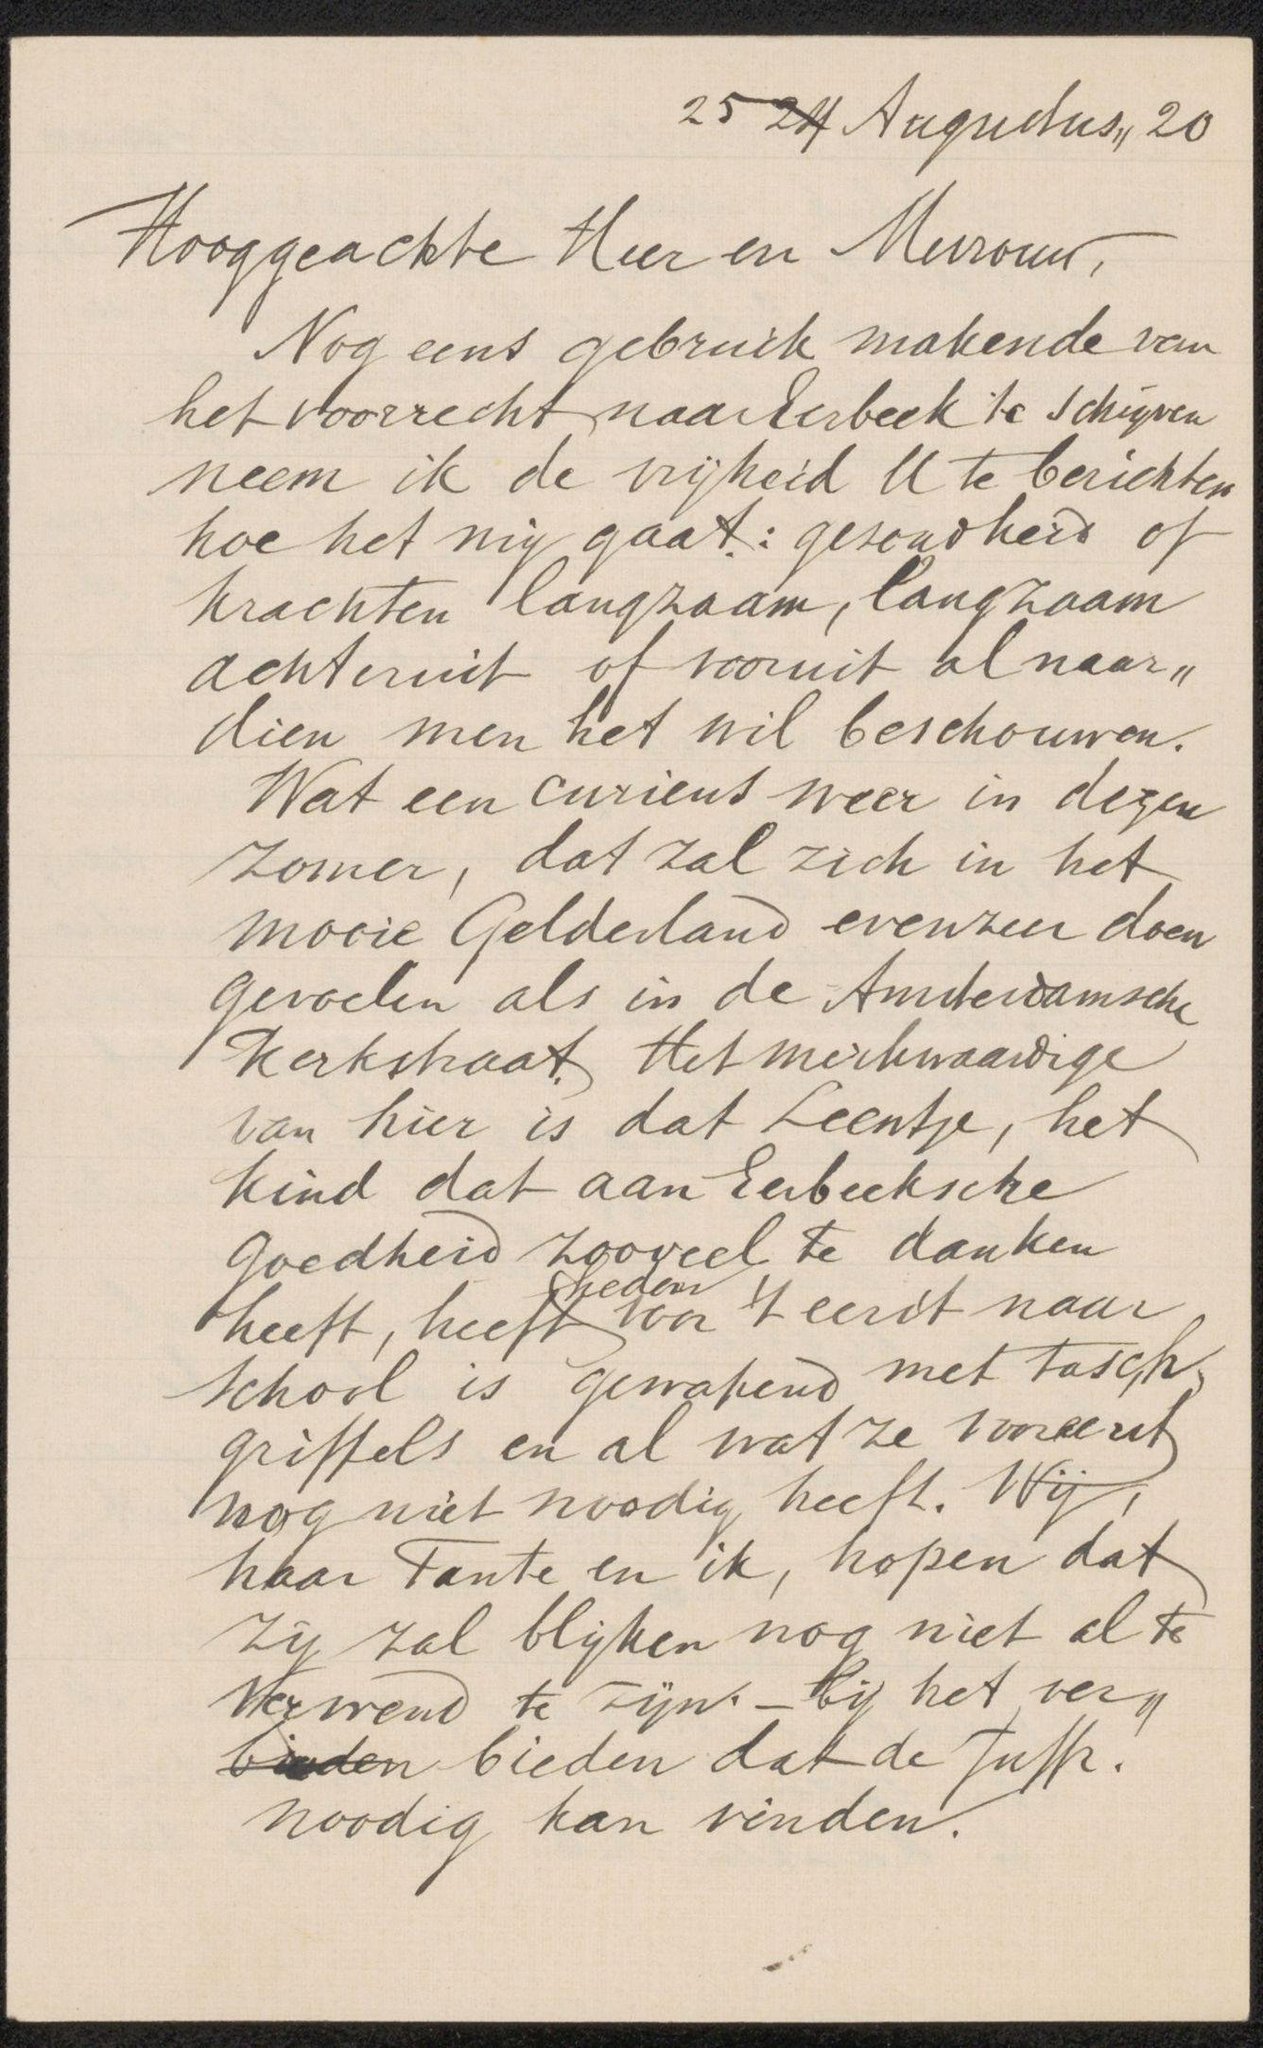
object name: letter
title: Brief aan Max Wilhelm Carl Weber en Anne Antoinette Weber-Van Bosse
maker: august allebé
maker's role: draughtsman, print maker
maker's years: 1838-1927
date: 1920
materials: ink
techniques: pen, writing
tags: albert charles auguste plasschaert, anne antoinette weber-van bosse, painter, jan mankes, criticizing and discussing art, art criticism, family life, travelling; tourism, exhibition ~ art, diseases, the hague, switzerland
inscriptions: watermark